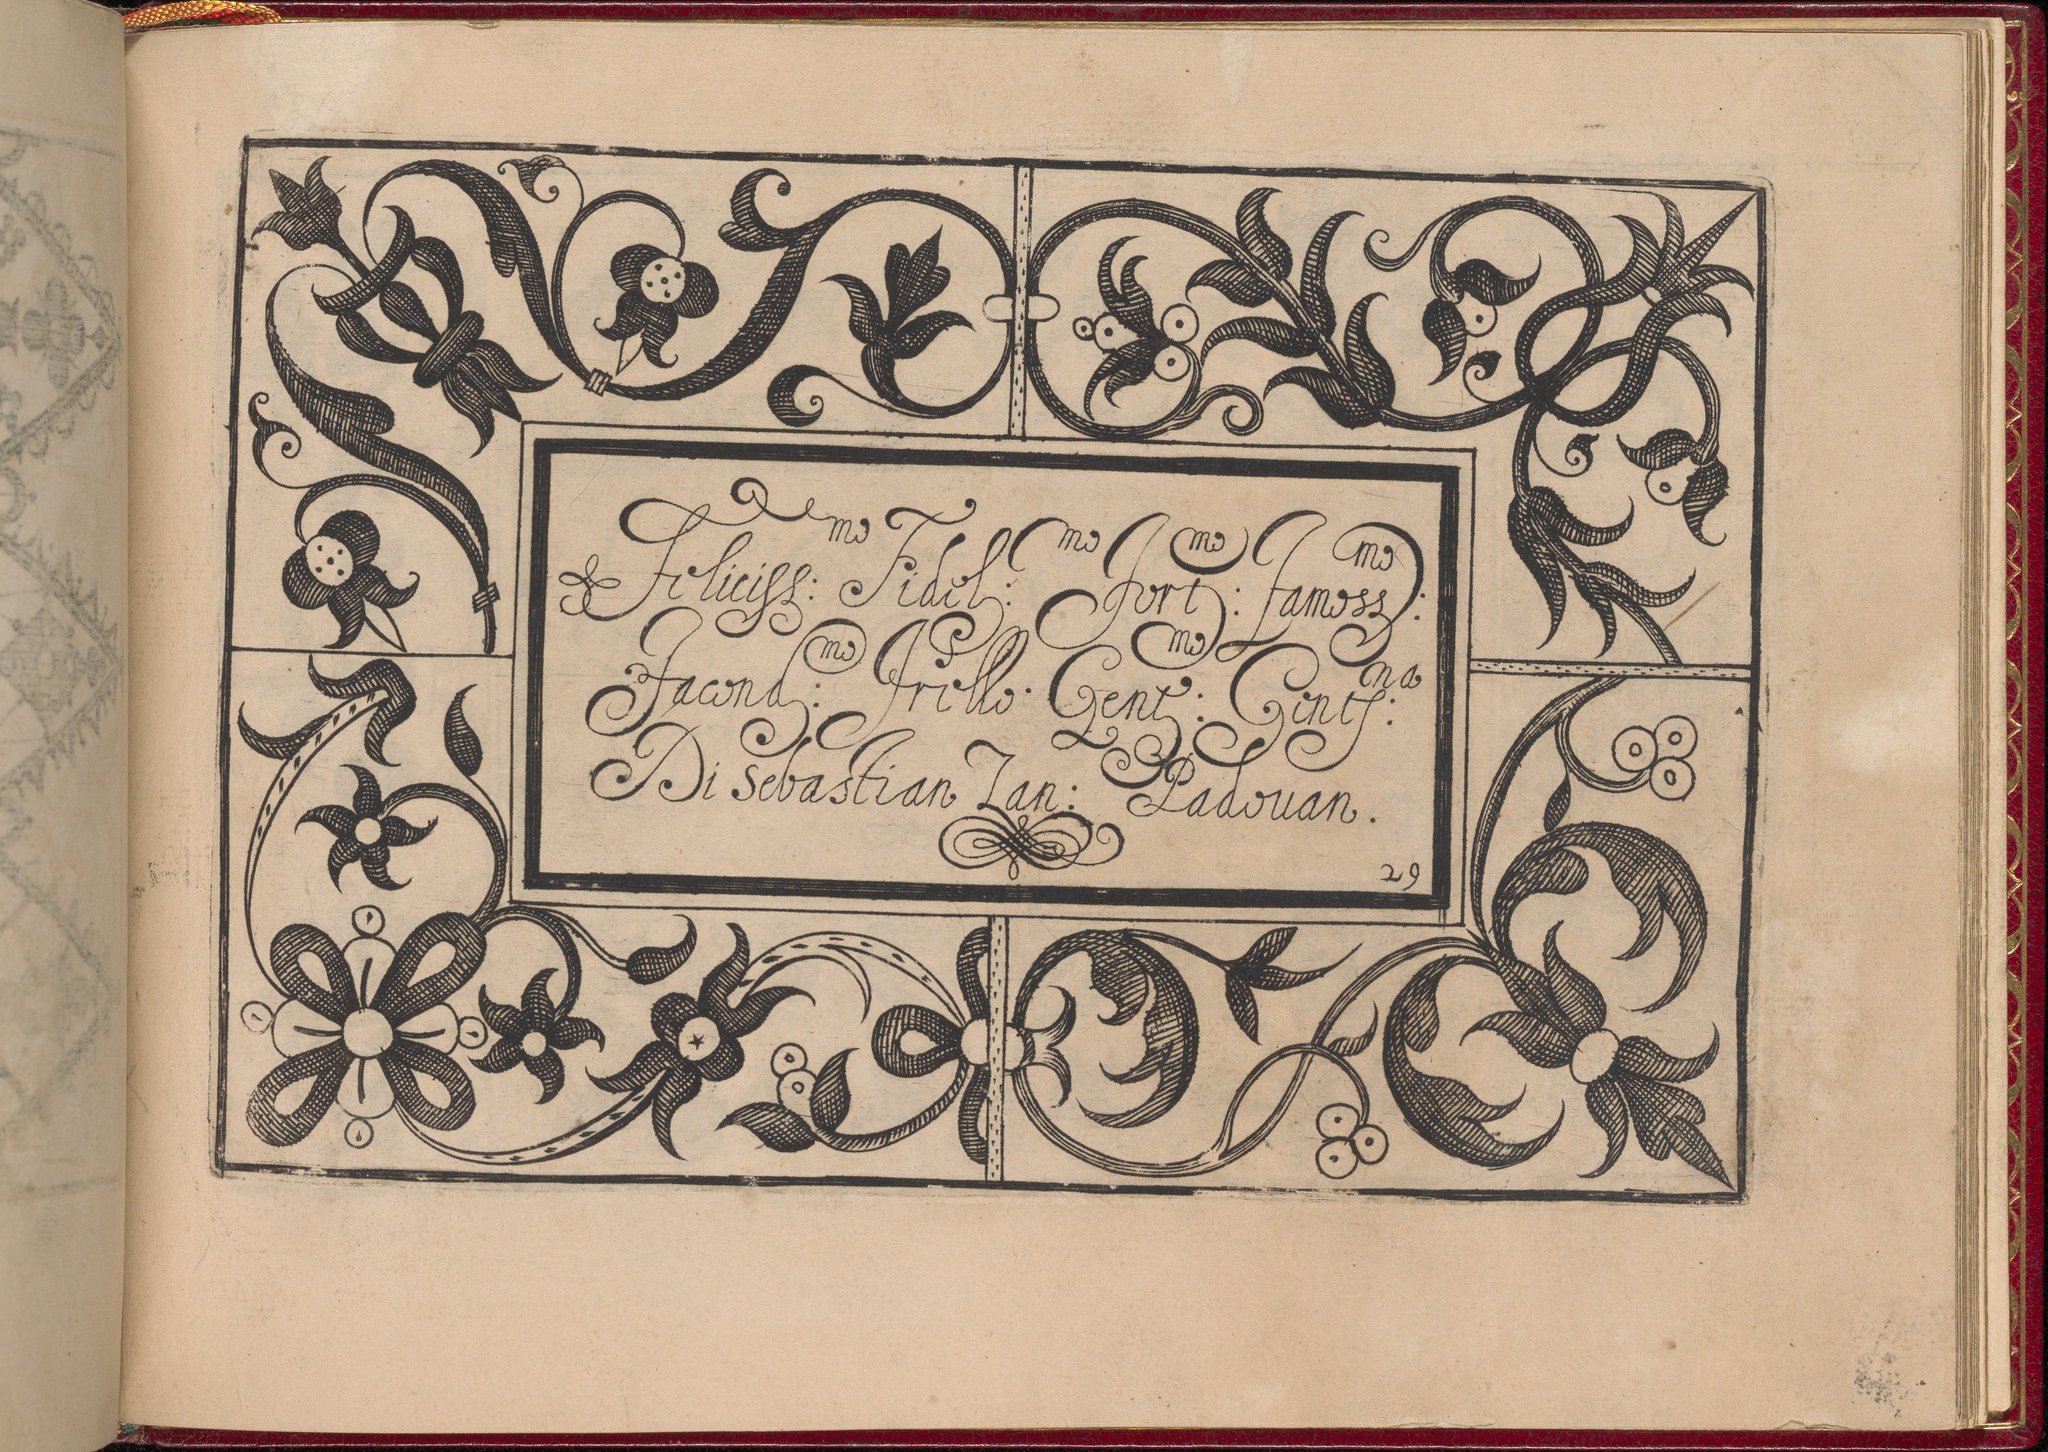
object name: book print ornament architecture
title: Ghirlanda: Di sei vaghi fiori scielti da piu famosi Giardini d'Italia, page 37 (recto)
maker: pietro paulo tozzi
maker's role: designer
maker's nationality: italian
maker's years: 1593-1628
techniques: drawing, etching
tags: flowers